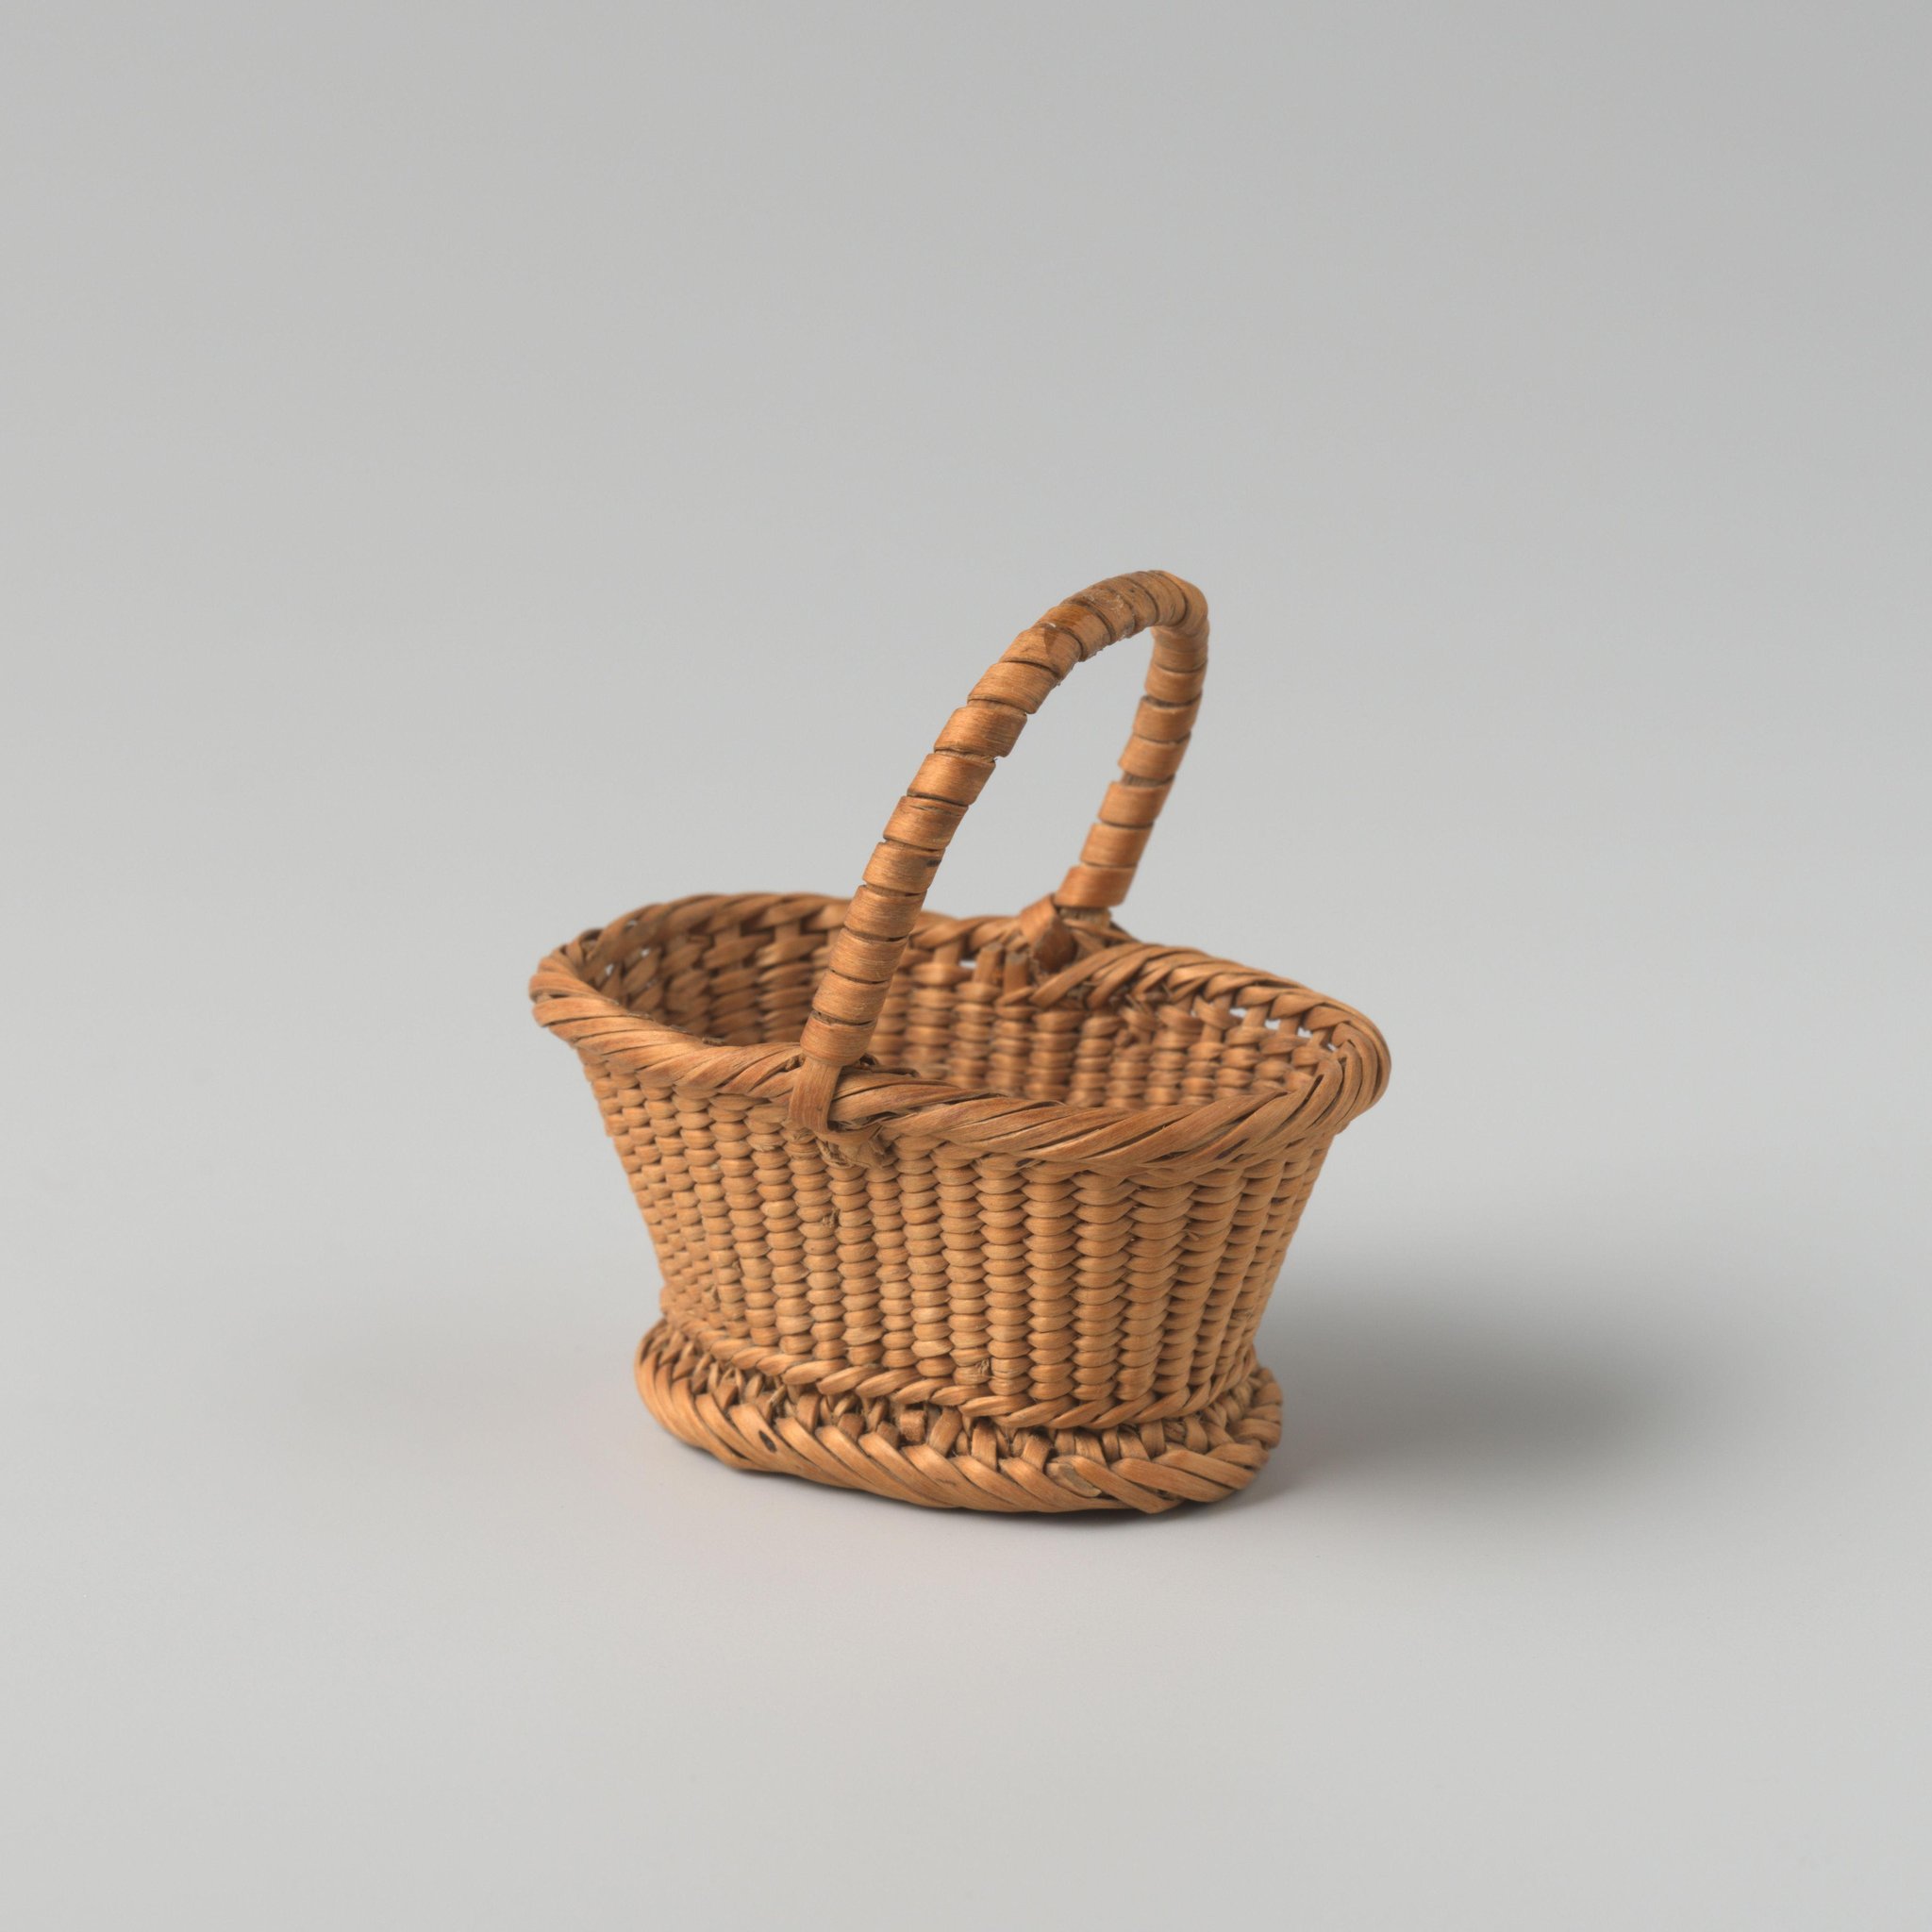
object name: miniature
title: Ovale hengselmand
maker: Anonymous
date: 1690-1710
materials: plant material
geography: halle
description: Ovale hengselmand van gespleten wilgenteen, fijnscheenwerk.